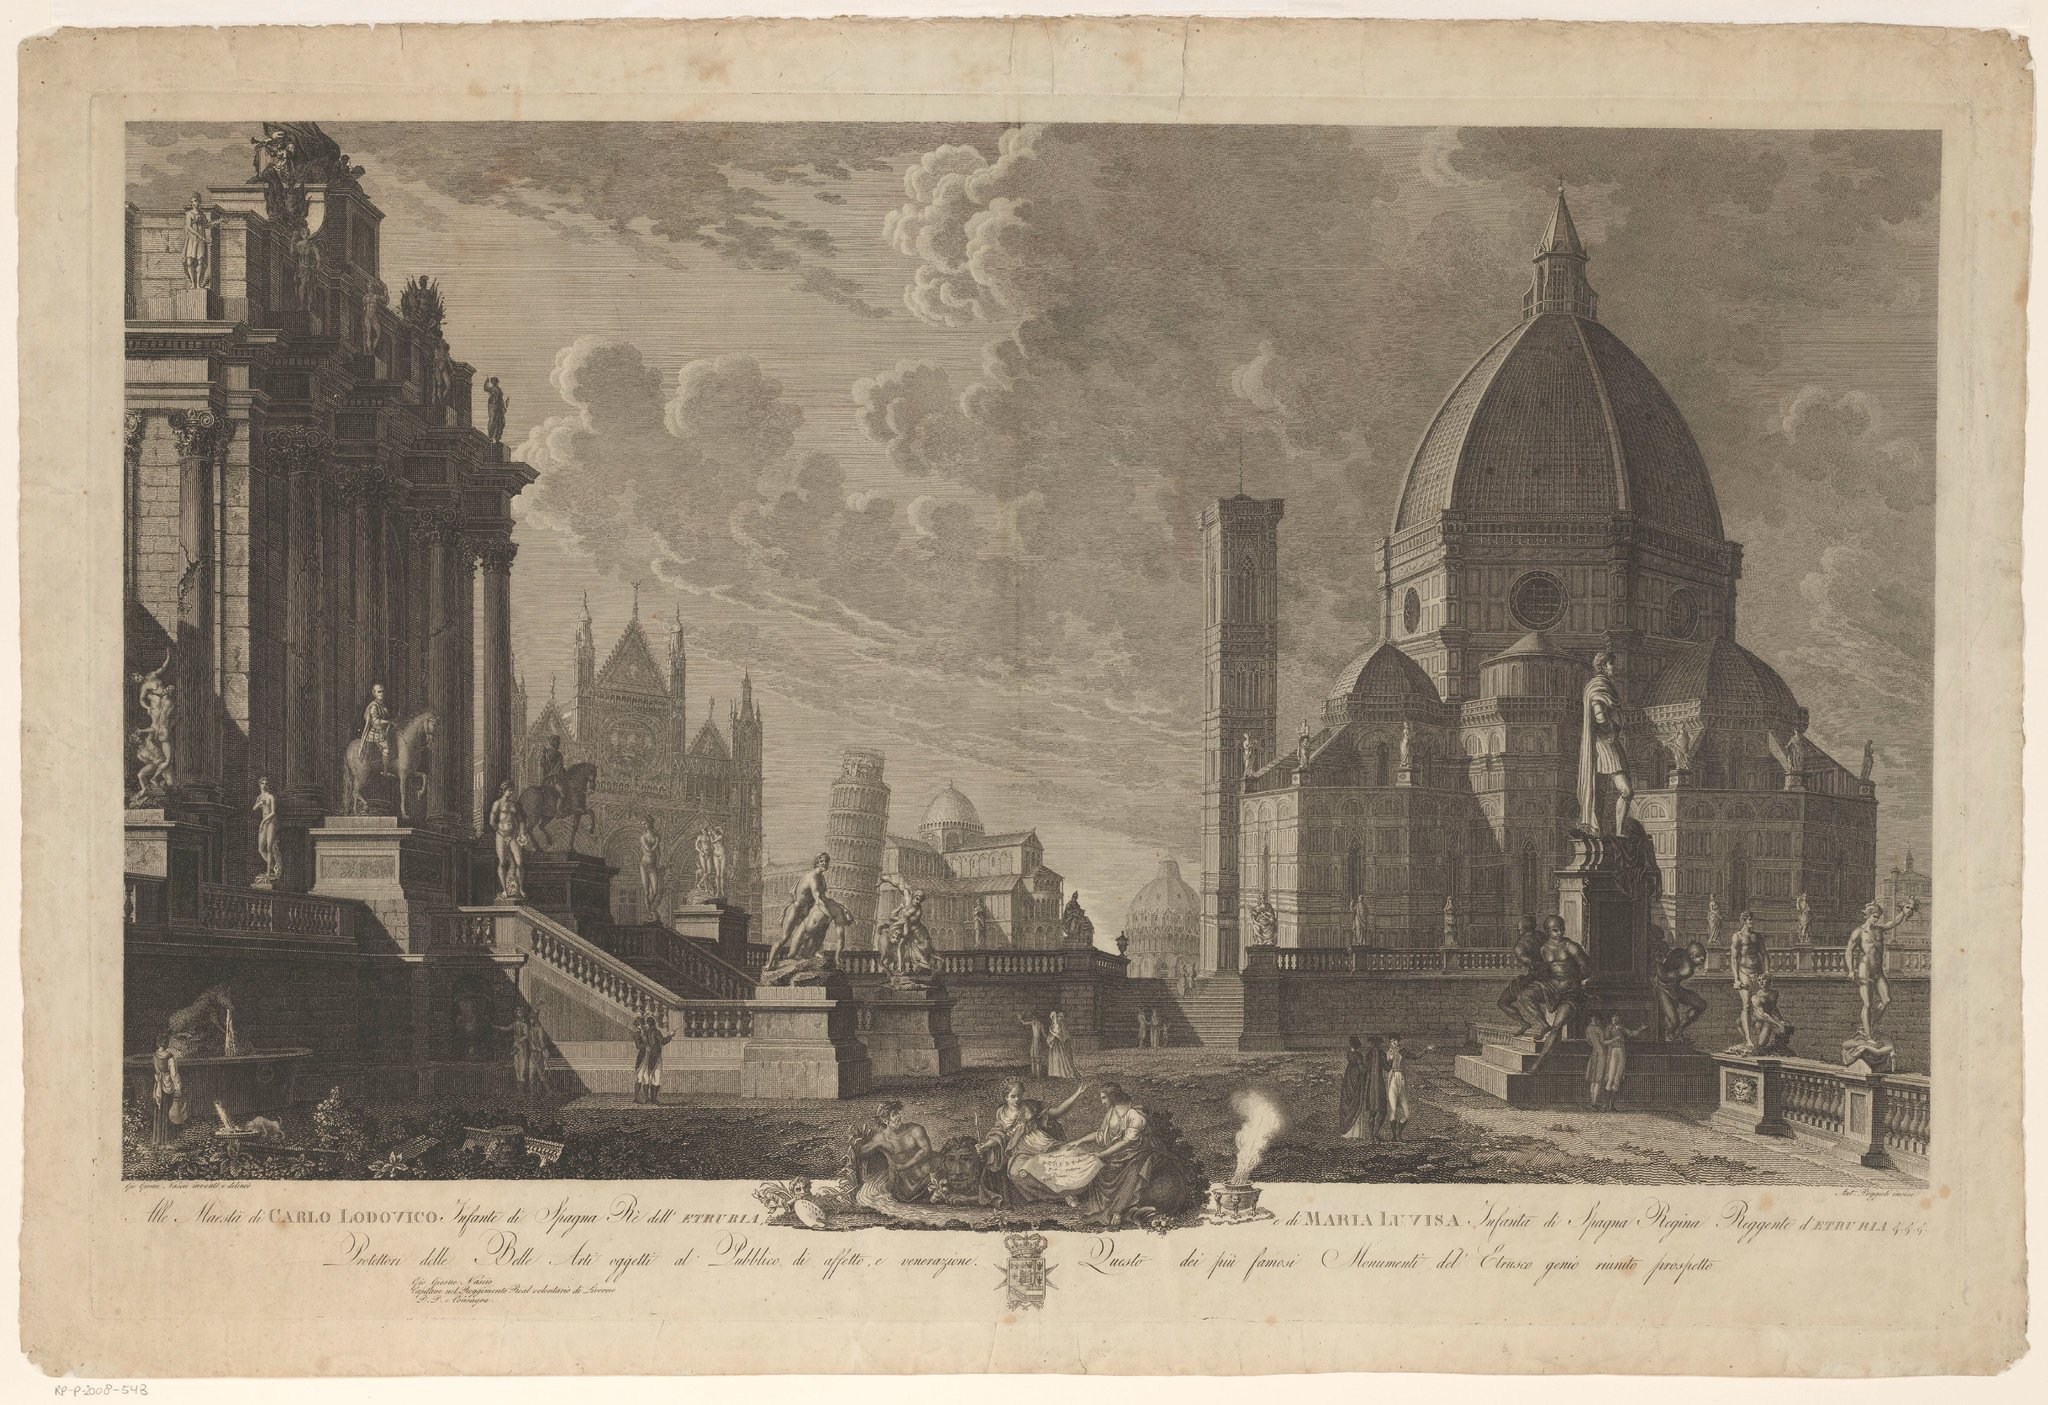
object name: print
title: Fantasie stadsgezicht met bouwwerken en sculpturen uit diverse Toscaanse steden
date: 1801-1803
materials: paper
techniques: etching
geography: italy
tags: ferdinando i de' medici, tower, clock tower ~ monumental adornment, church (exterior), slavery; serfs and enslaved persons, piece of sculpture, reproduction of a piece of sculpture, city-view in general; 'veduta' - ii - ideal city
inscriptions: collector's mark: Lugt 2228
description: Een fantasie stadsgezicht met bouwwerken en sculpturen uit diverse Toscaanse steden. Van links naar rechts: de Dom van Siena, de toren, de kathedraal en het baptisterium van Pisa en de Dom met campanille van Florence. Op de voorgrond staan onder andere het standbeeld van Ferdinando I de' Medici met de beelden van de vier tot slaaf gemaakte 'Moren' (I Quattro Mori) uit de haven van Livorno, de Sabijnse Maagdenroof door Giambologna, Perseus door Benvenuto Cellini en Hercules and Cacus door Baccio Bandinelli. Opdracht in ondermarge.